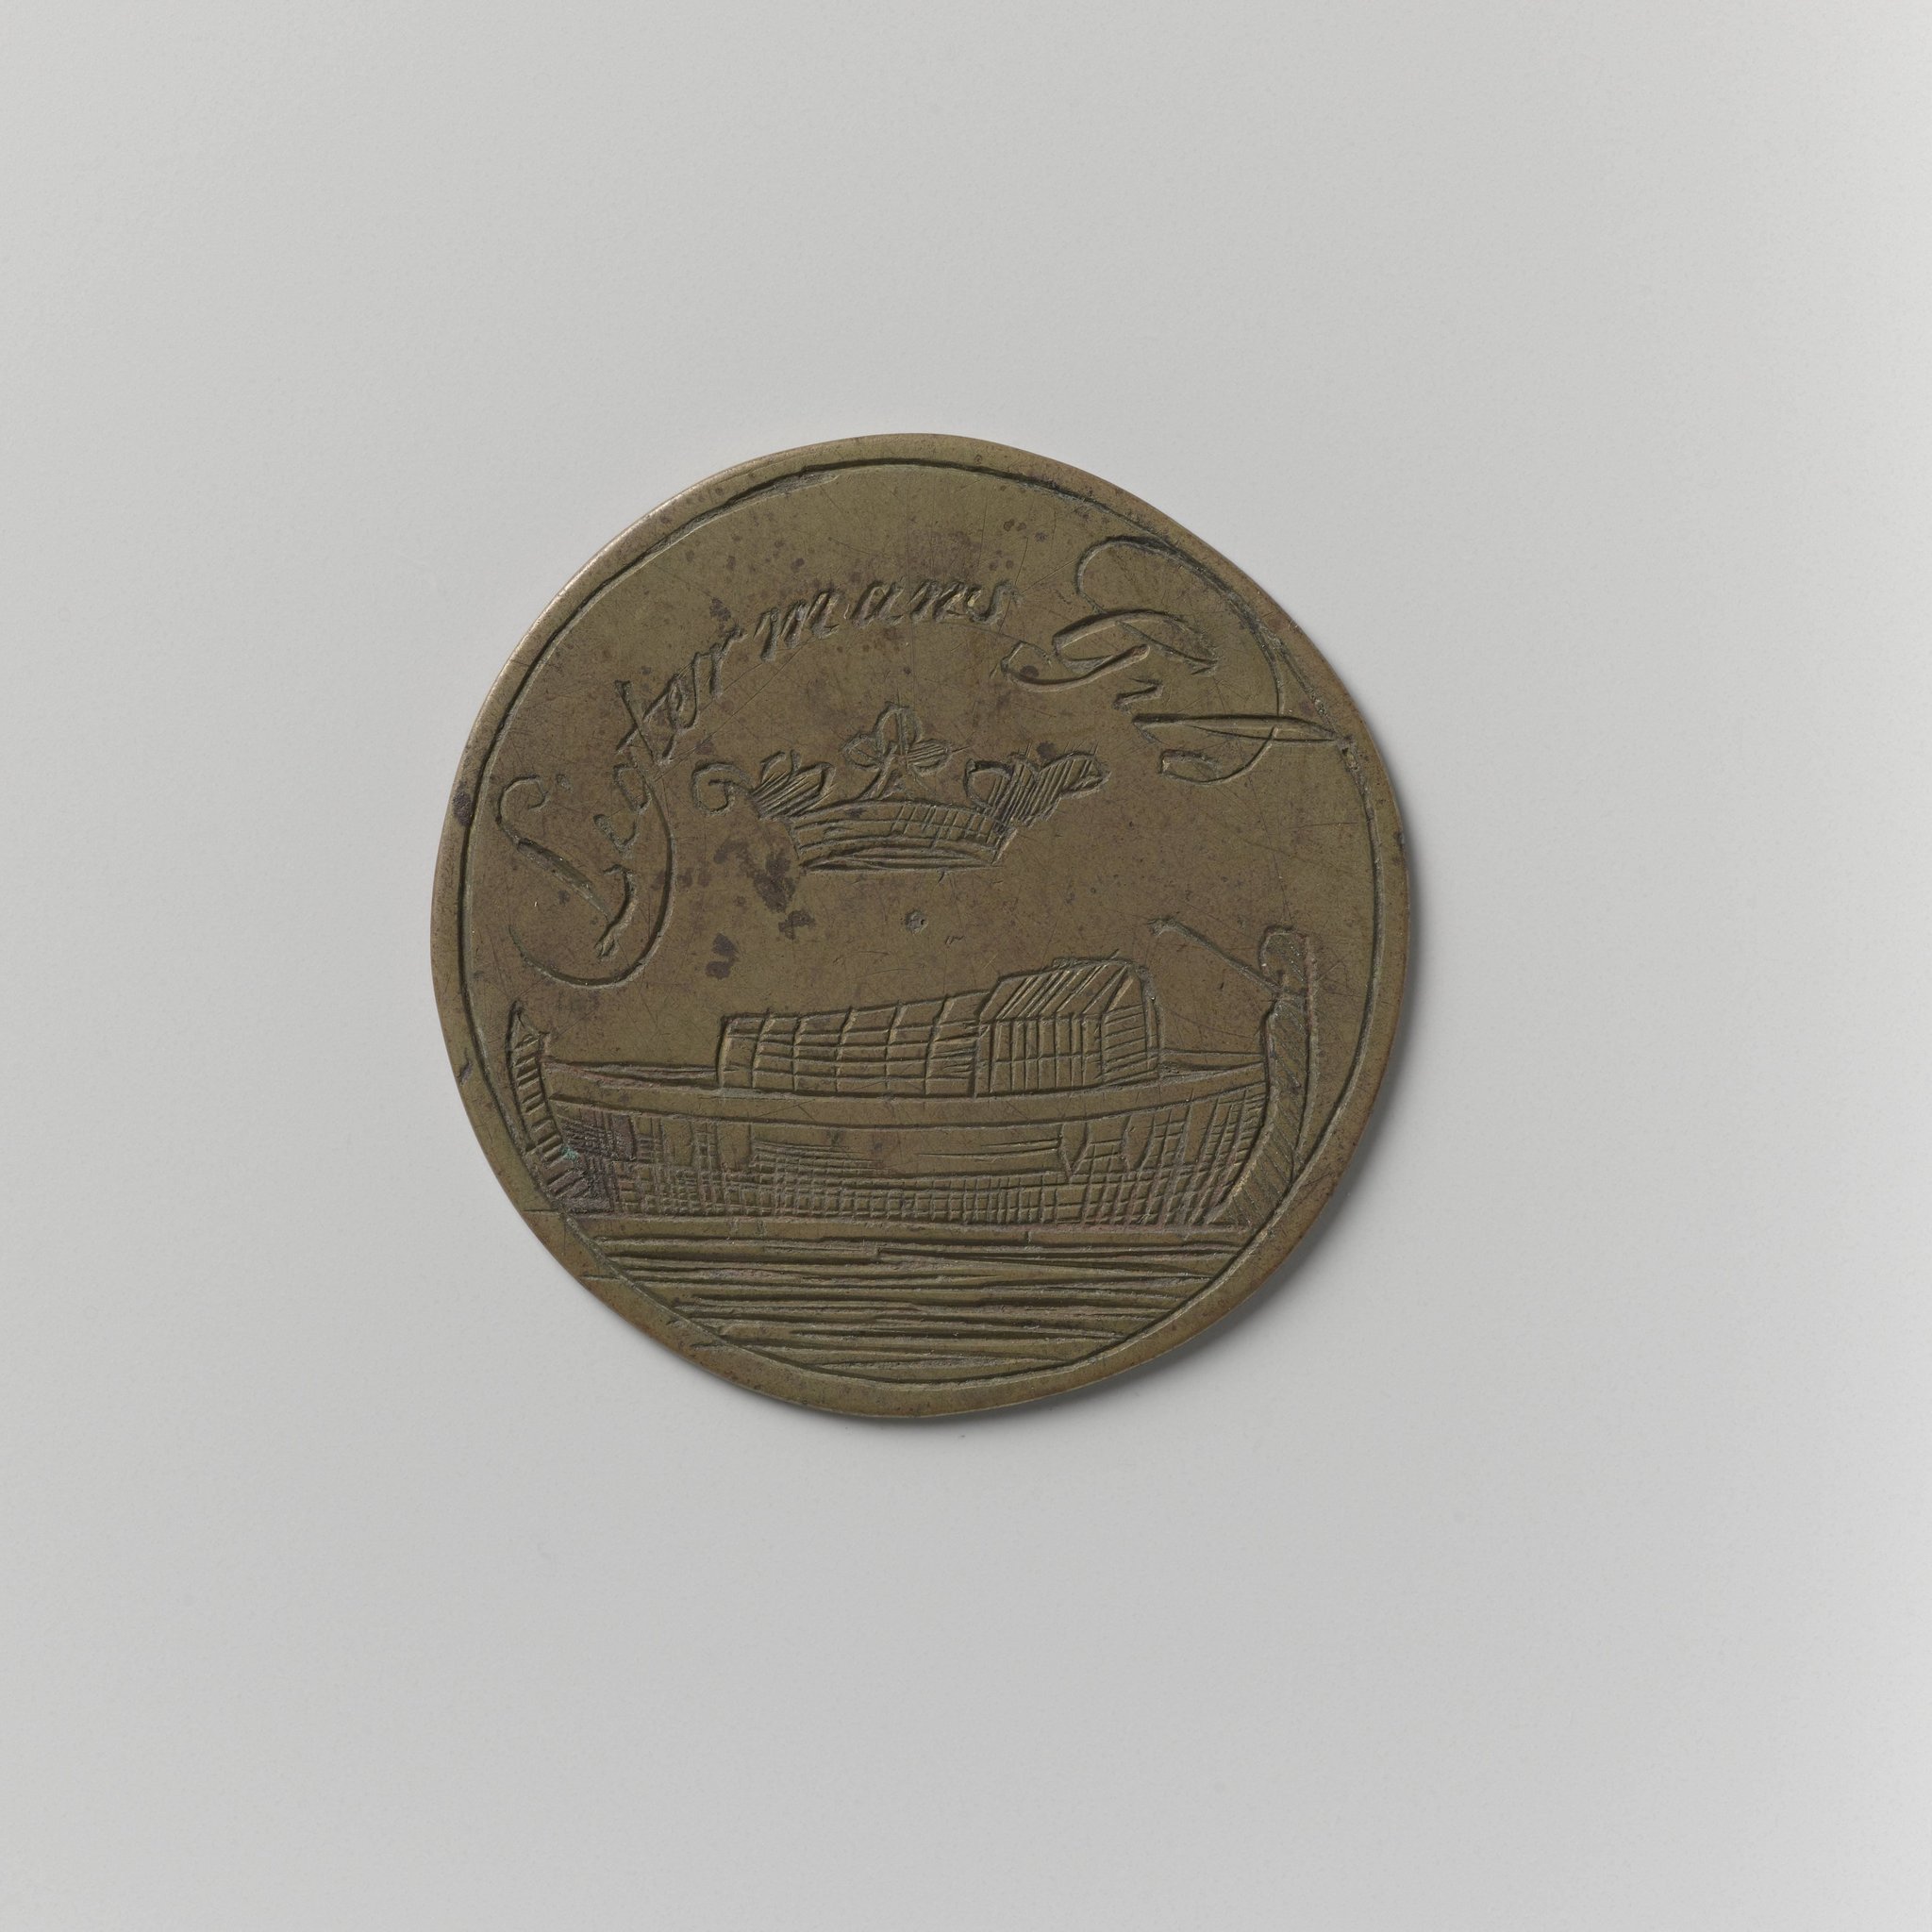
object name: medal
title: Korenlichtermansgilde van Amsterdam, gildepenning van Willem van de Water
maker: Anonymous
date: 1773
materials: brass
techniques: engraving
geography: amsterdam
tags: amsterdam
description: Messing penning. Voorzijde: gekroonde korenlichter onder opschrift. Keerzijde: opschrift